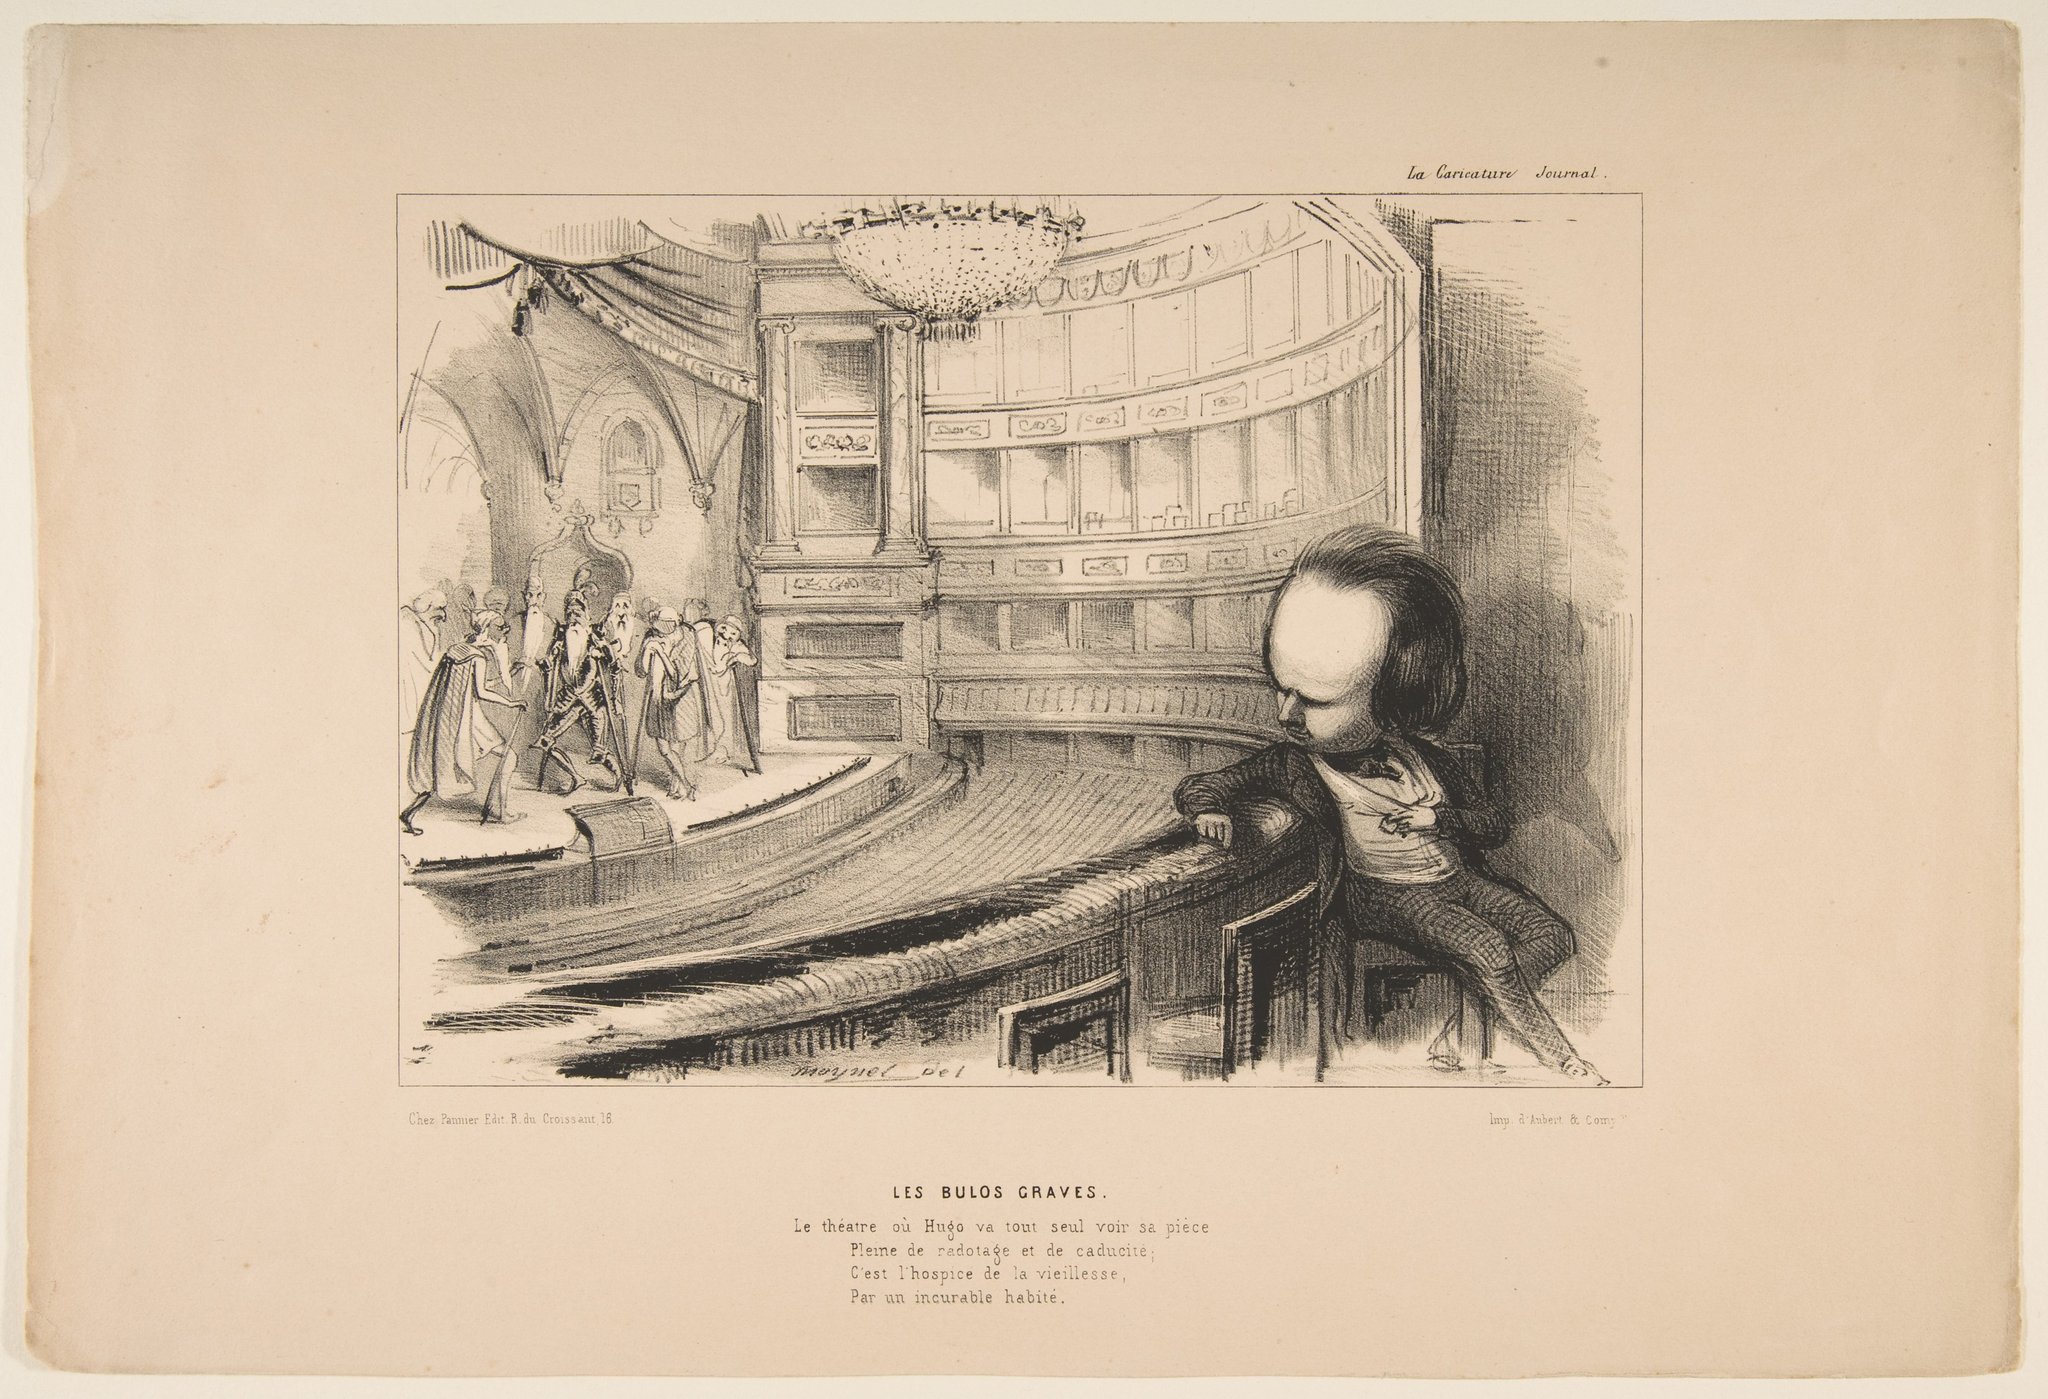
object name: print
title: 'Les Bulos Graves', Victor Hugo at his play 'Les Burgraves', from 'La Caricature'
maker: jean-pierre moynet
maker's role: artist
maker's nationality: french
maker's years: 1819-1876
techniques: lithograph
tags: theatre,men,caricature